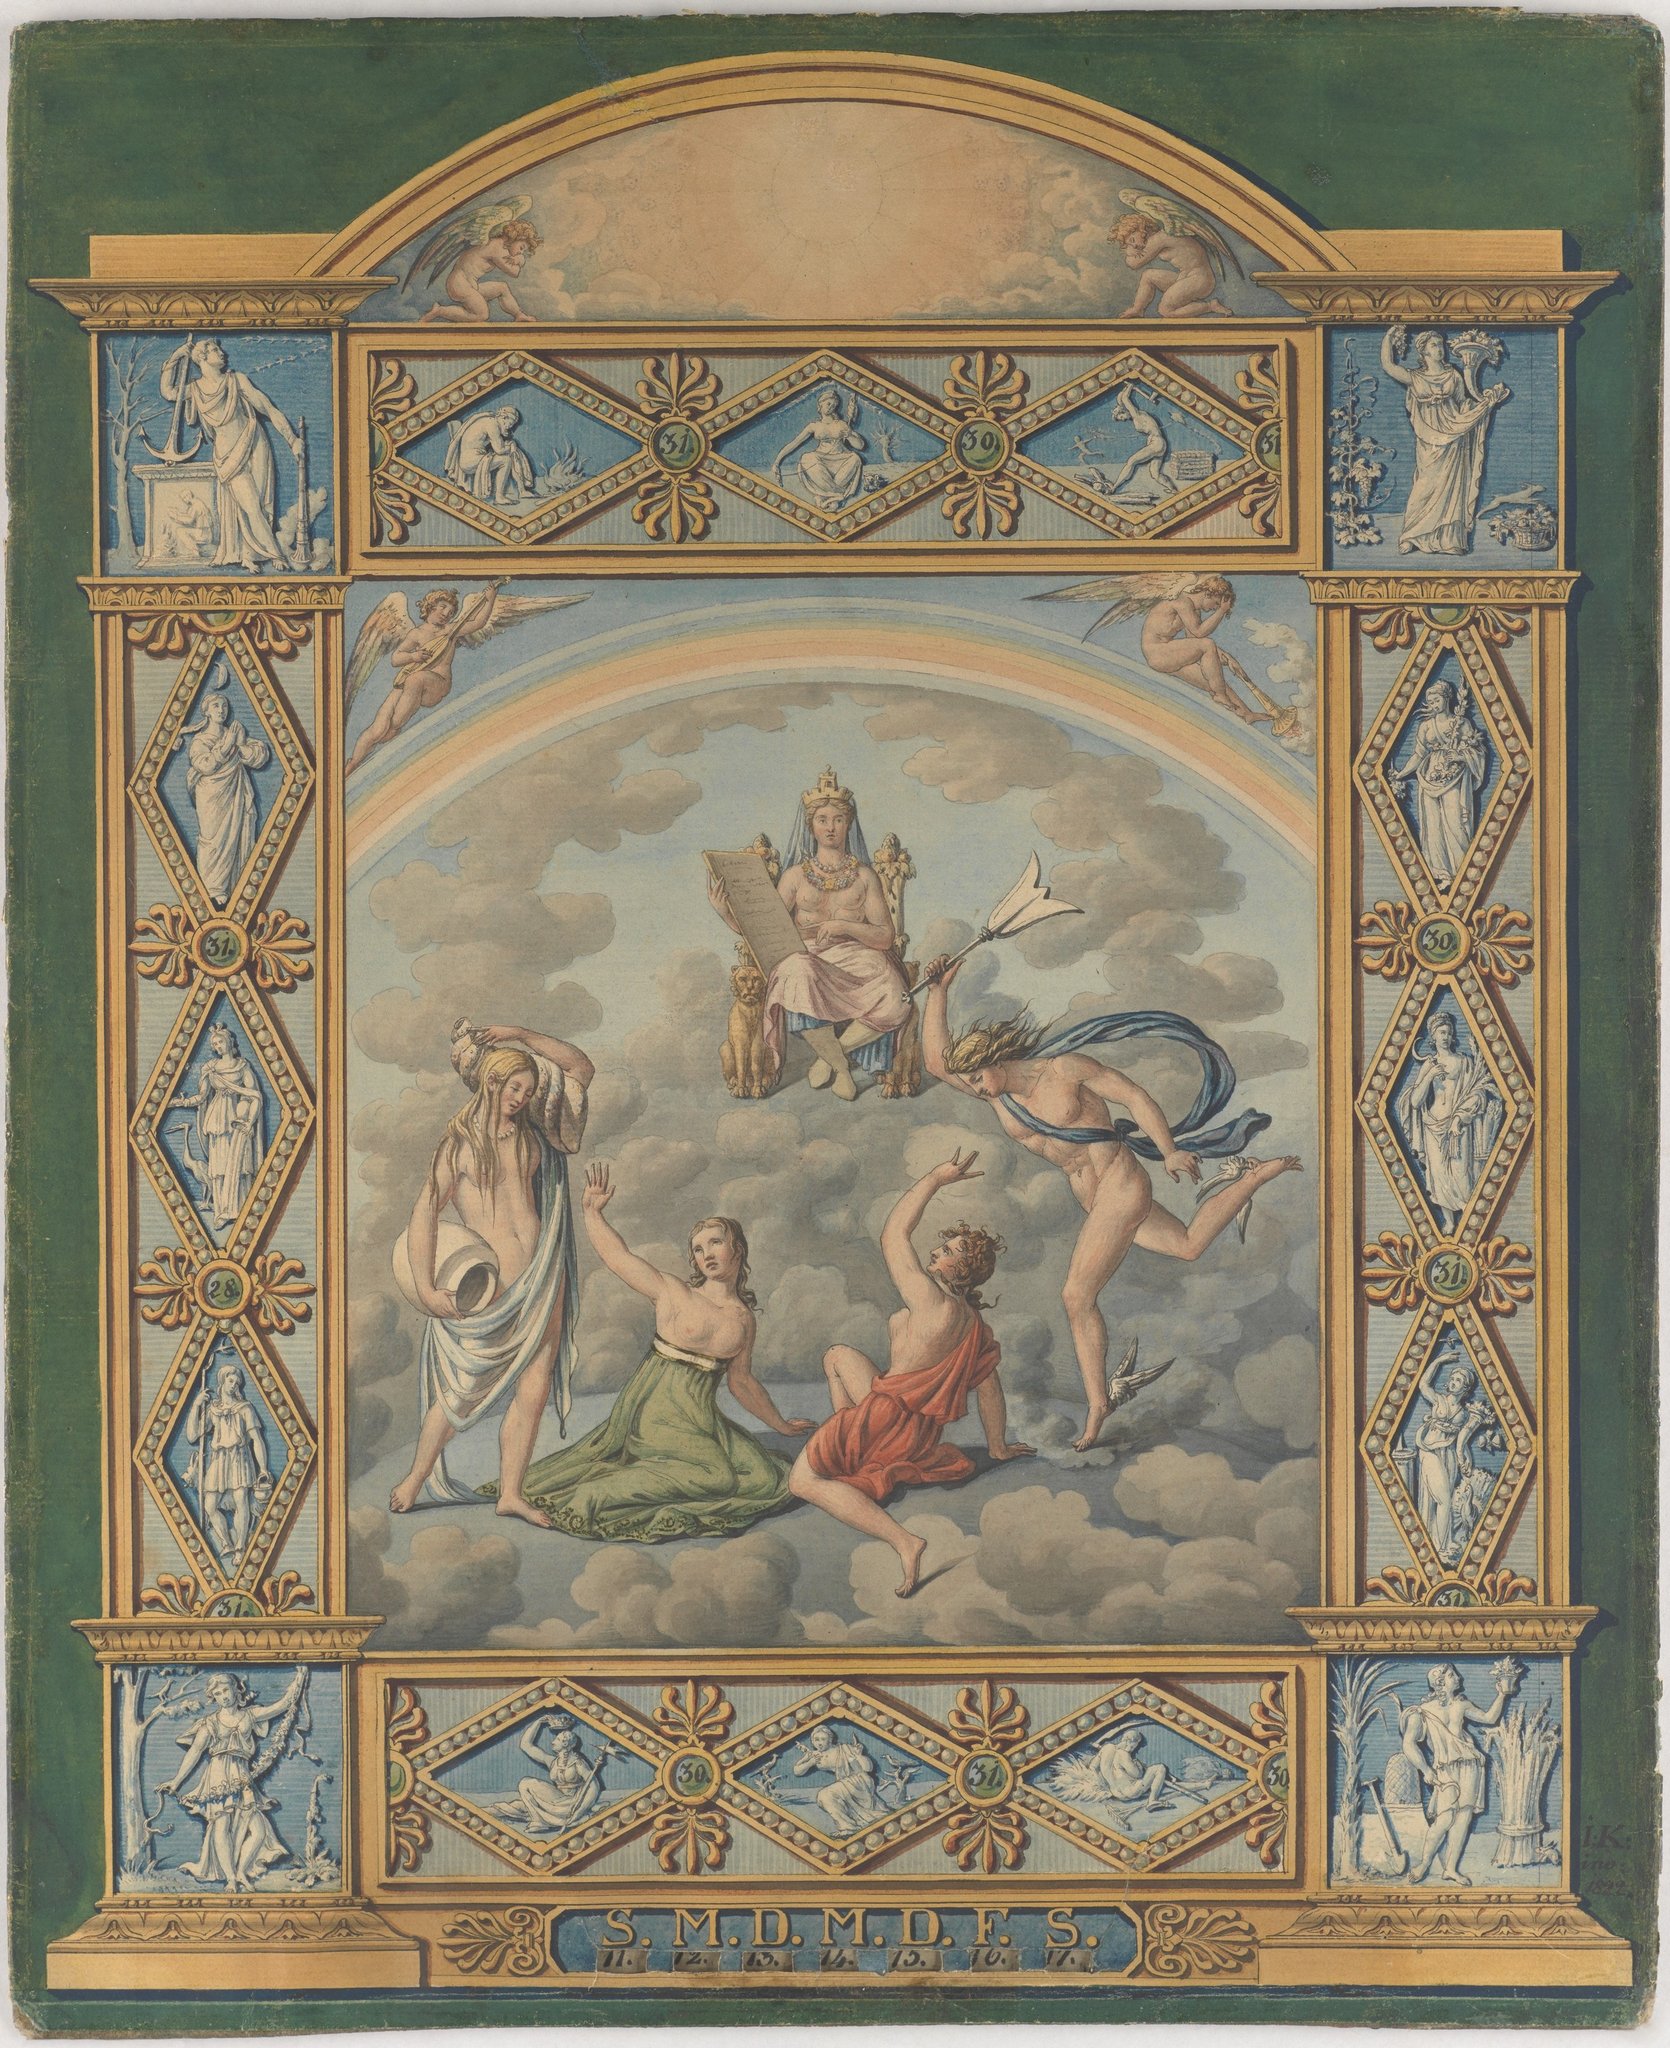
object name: drawing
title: Weekly Calendar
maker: joseph anton koch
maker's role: artist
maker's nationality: austrian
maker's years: 1768-1839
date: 1822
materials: ink, watercolor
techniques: pen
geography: germany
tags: male nudes,female nudes,lions,calendars